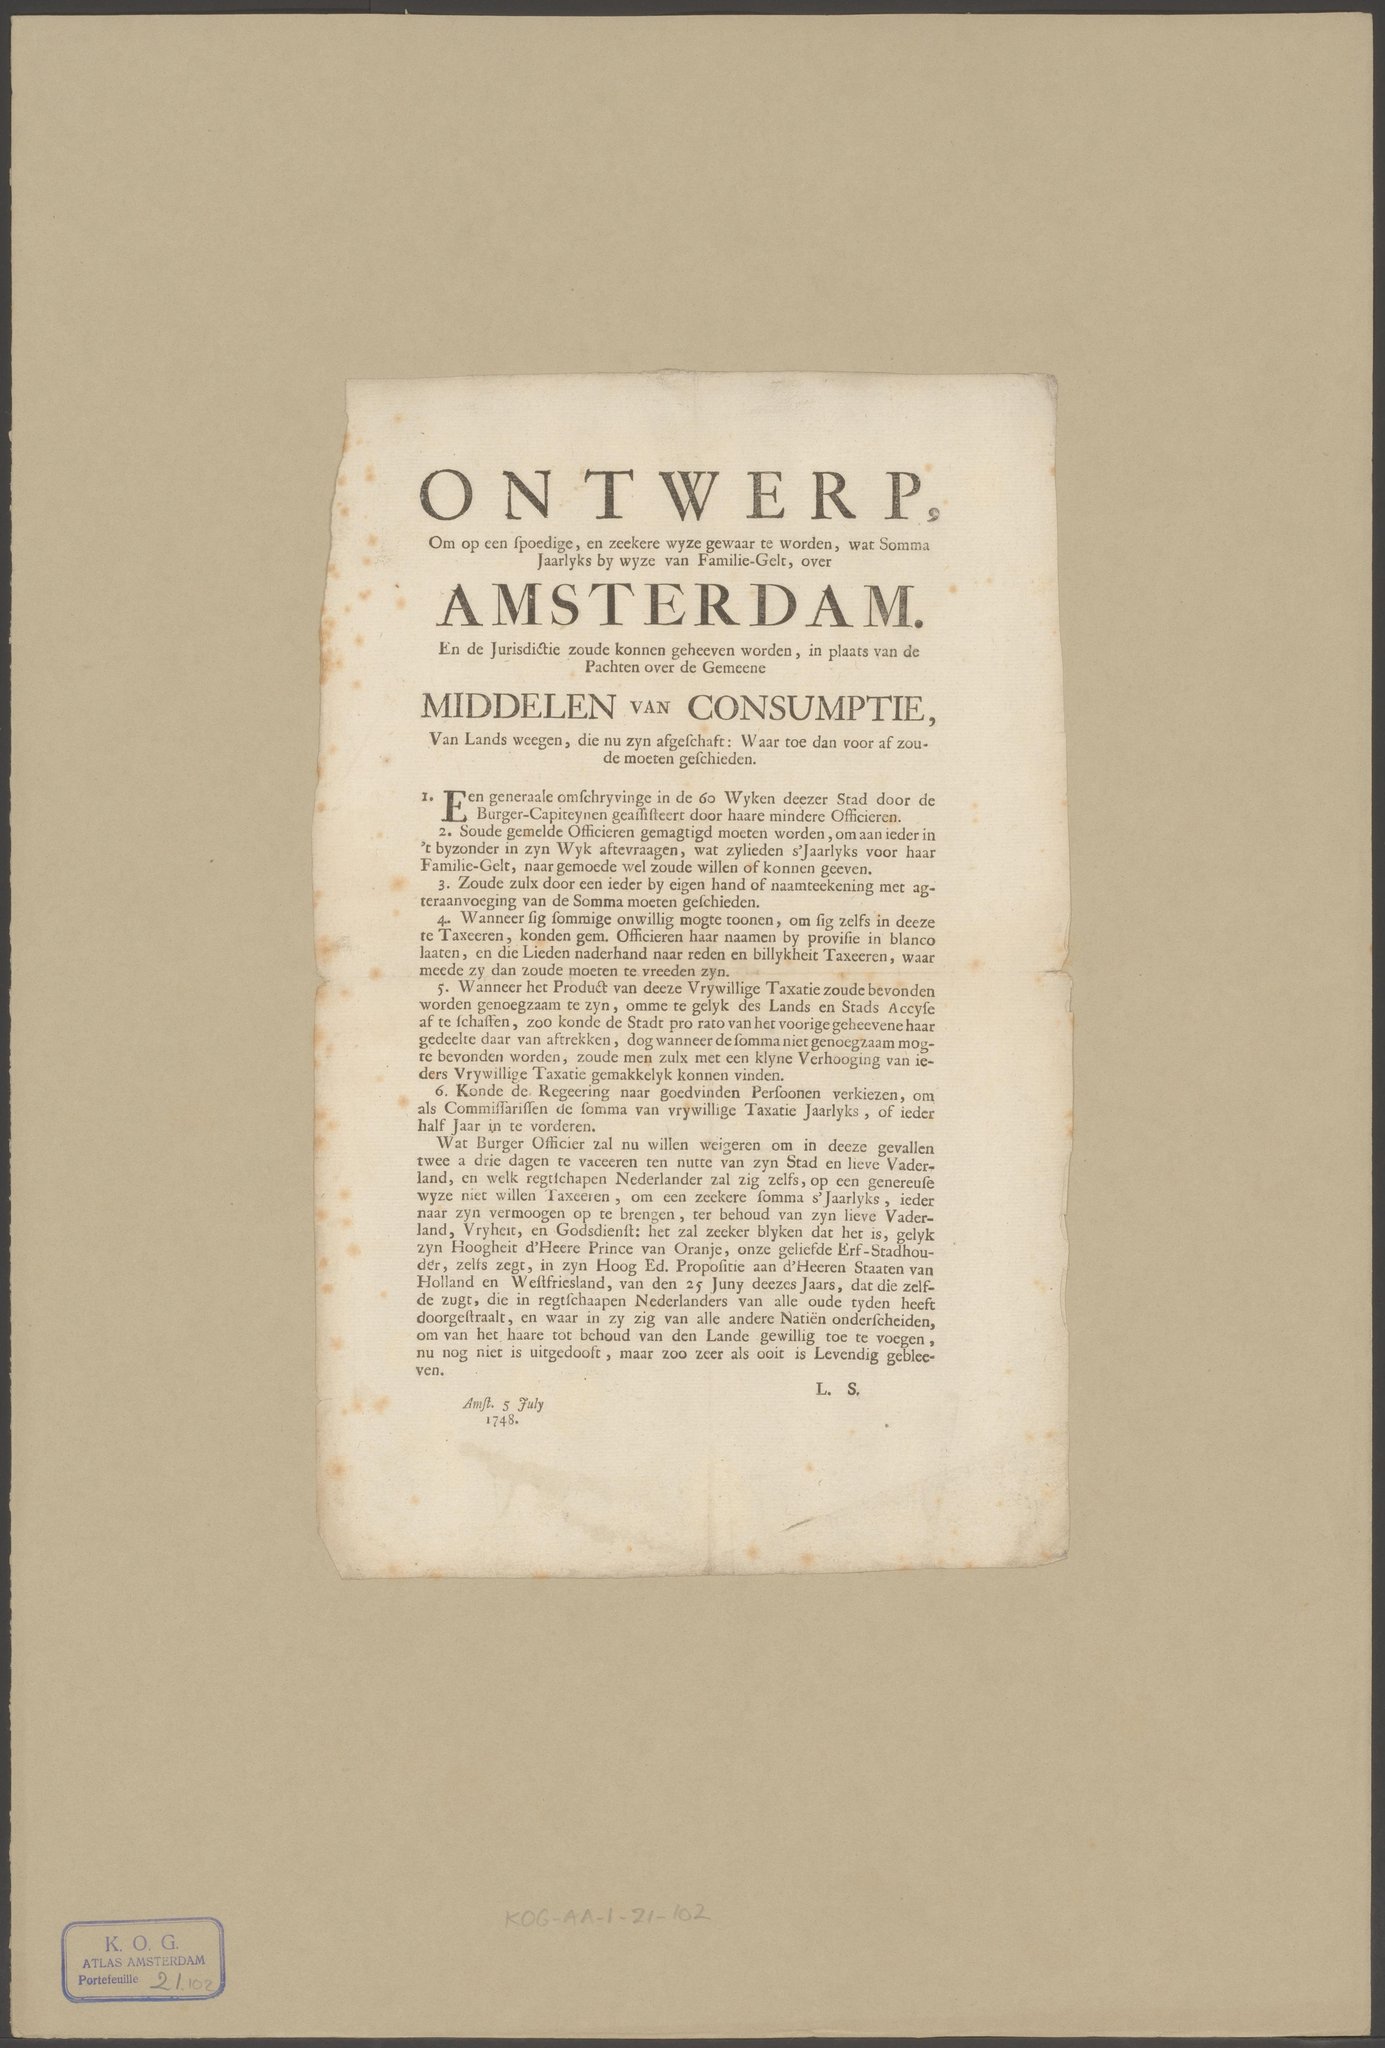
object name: document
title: Pamflet met belastingvoorstel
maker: Anonymous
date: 1748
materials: paper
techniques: letterpress printing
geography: amsterdam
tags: tax collection, tax payment, amsterdam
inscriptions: collector's mark: Lugt 1641b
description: Inzake nieuw te heffen vermogensbelasting van inwoners van Amsterdam, met zes stappen om dit uit te voeren. Onderwerpsrubriek binnen de Atlas Amsterdam: Belastingen.